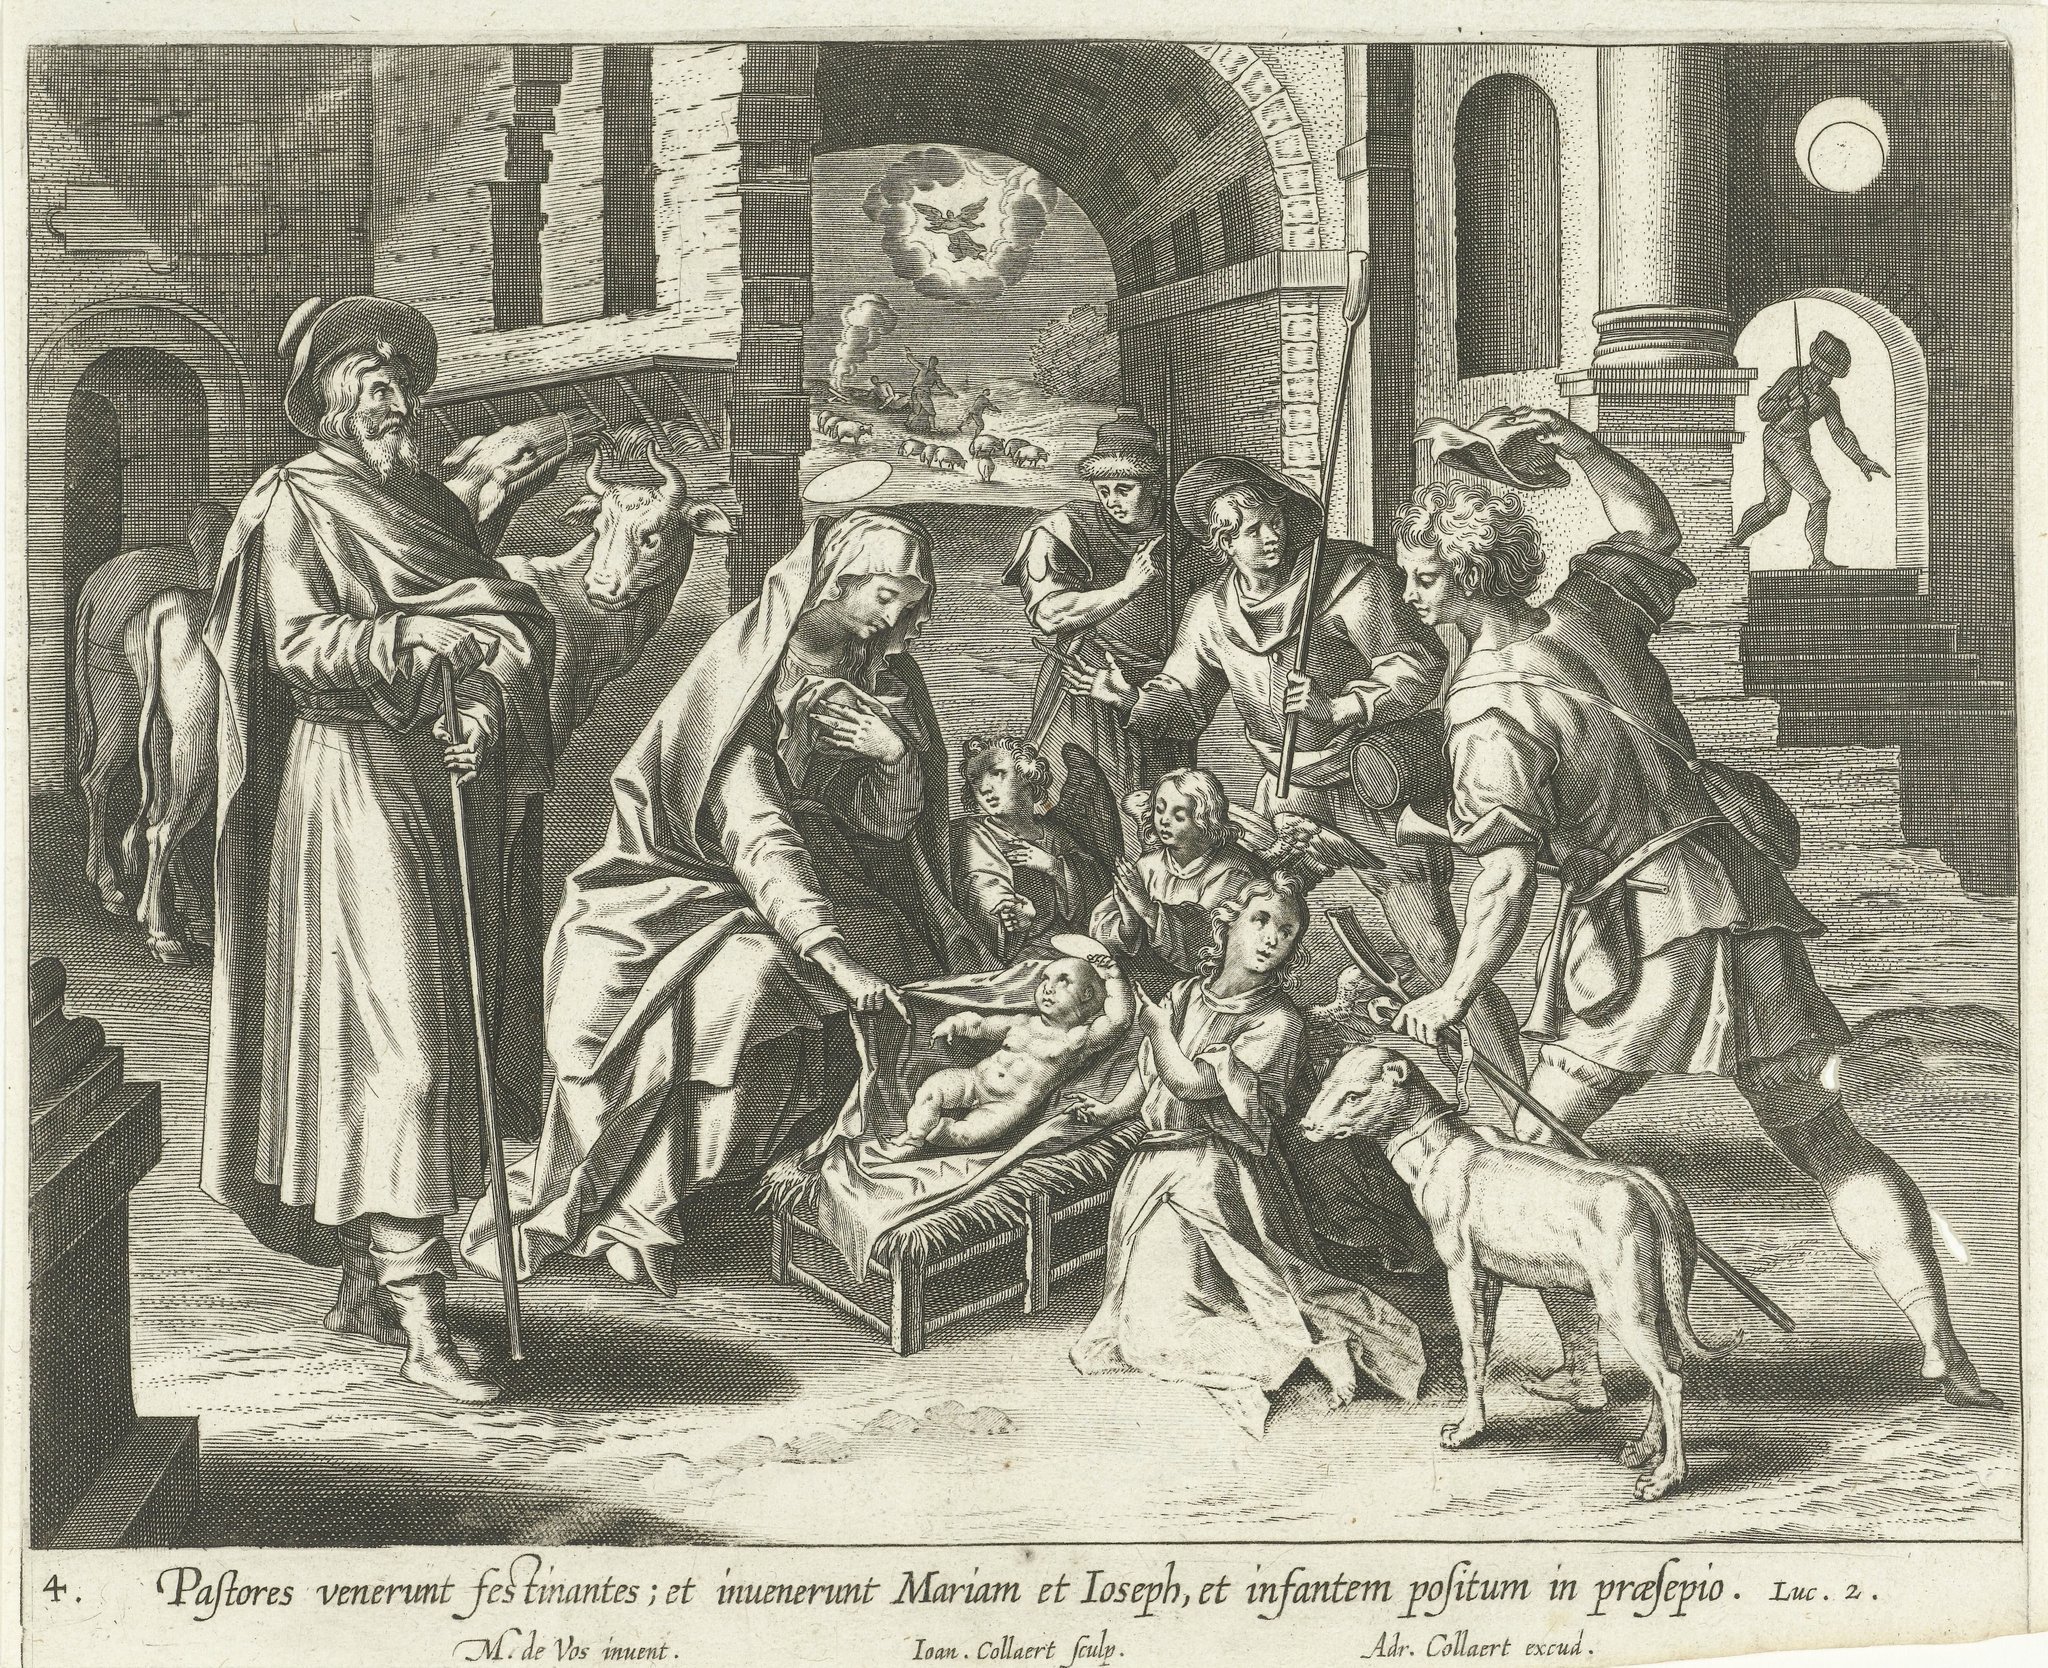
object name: print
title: Aanbidding door de herders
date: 1598-1618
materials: paper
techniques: engraving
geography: antwerp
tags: adoration of the christ-child by the shepherds; mary and joseph present (+ angel(s))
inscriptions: inscription: ‘behorende op A. Collaert (15 stuks), J. Collaert (6 stuks), Jan de Bye (17 stuks), Barbé (6 stuks), Galle (7 stuks): 51 stuks’, collector's mark: Lugt 2228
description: Nadat Gabriël aan de herders de geboorte van Christus heeft aangekondigd, bezoeken zij de stal en de kribbe met het Christuskind (Lucas 2:8-20). Naast Maria en Jozef zijn enkele engelen aanwezig, alsook de os en de ezel. De prent heeft een Latijns onderschrift. De prent maakt deel uit van een serie over het leven van Christus.